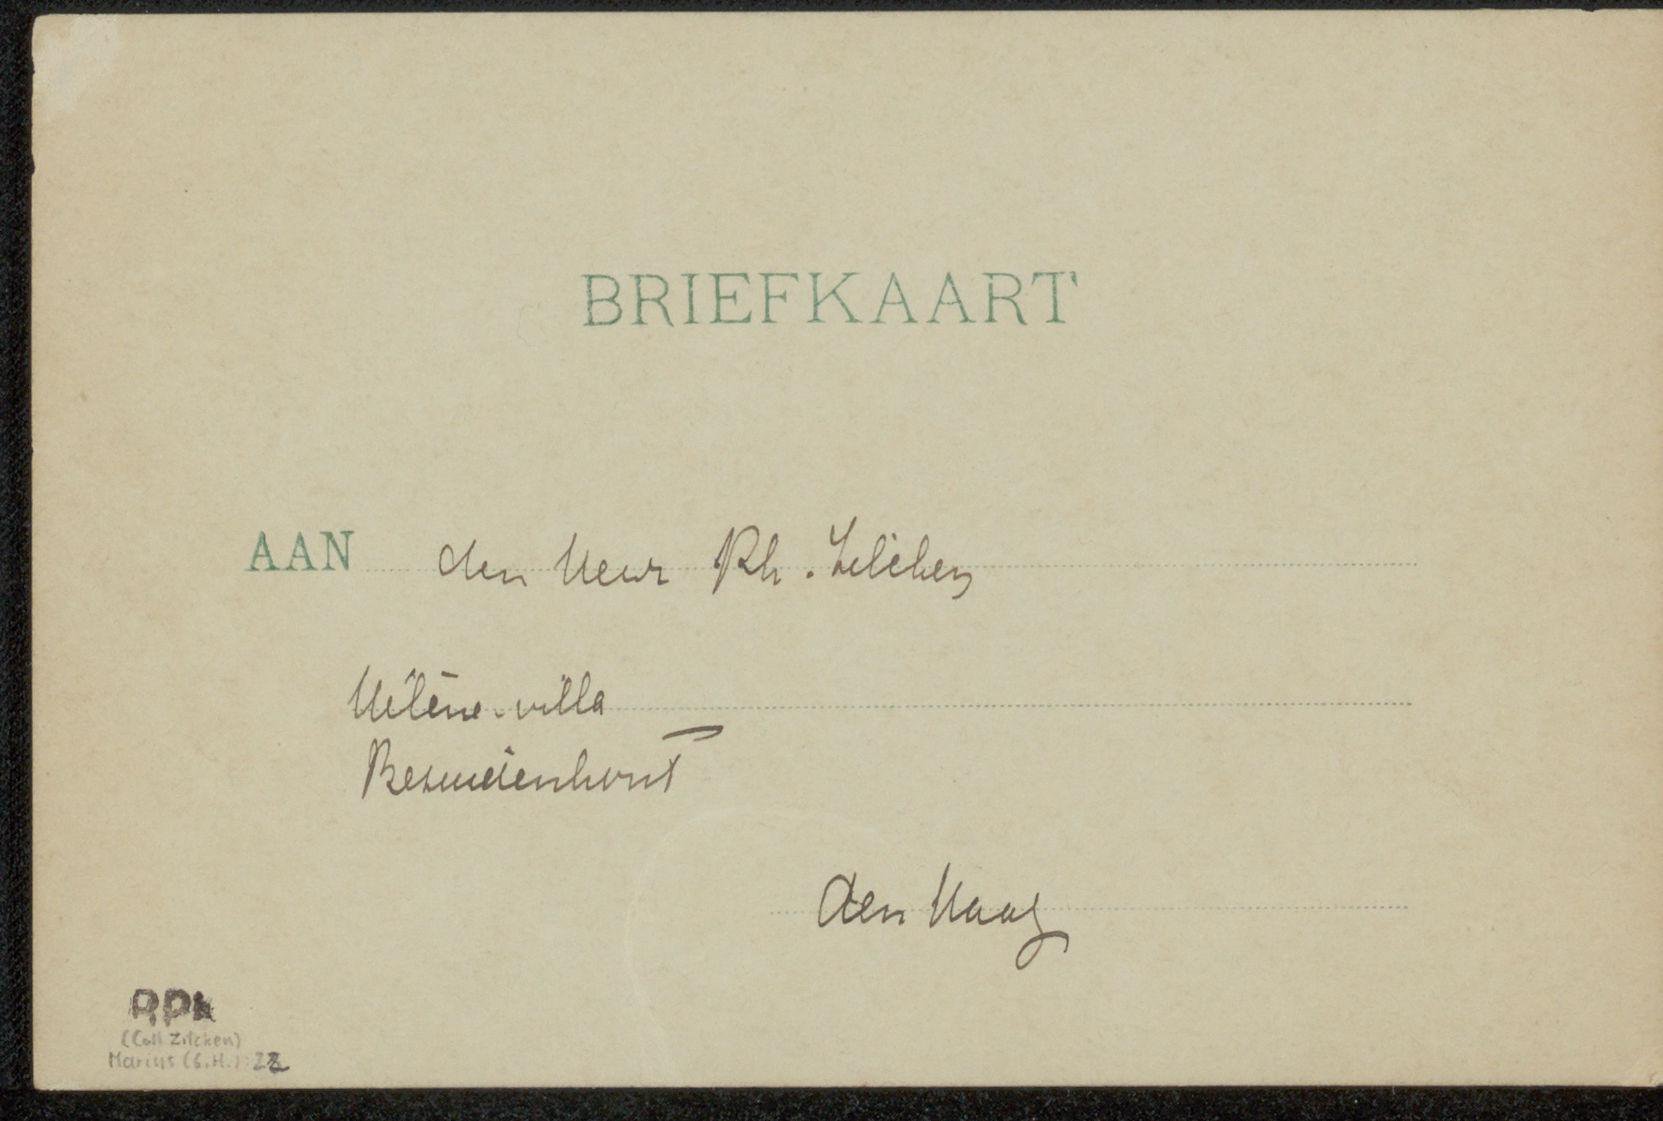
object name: postcard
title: Briefkaart aan Philip Zilcken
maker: grada hermina marius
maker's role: painter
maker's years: 1854-1919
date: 1864-1919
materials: cardboard, ink, pencil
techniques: pen, writing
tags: the hague, painter, draughtsman, philip zilcken, anonymous historical person portrayed, printed matter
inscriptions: collector's mark: ‘RPK’